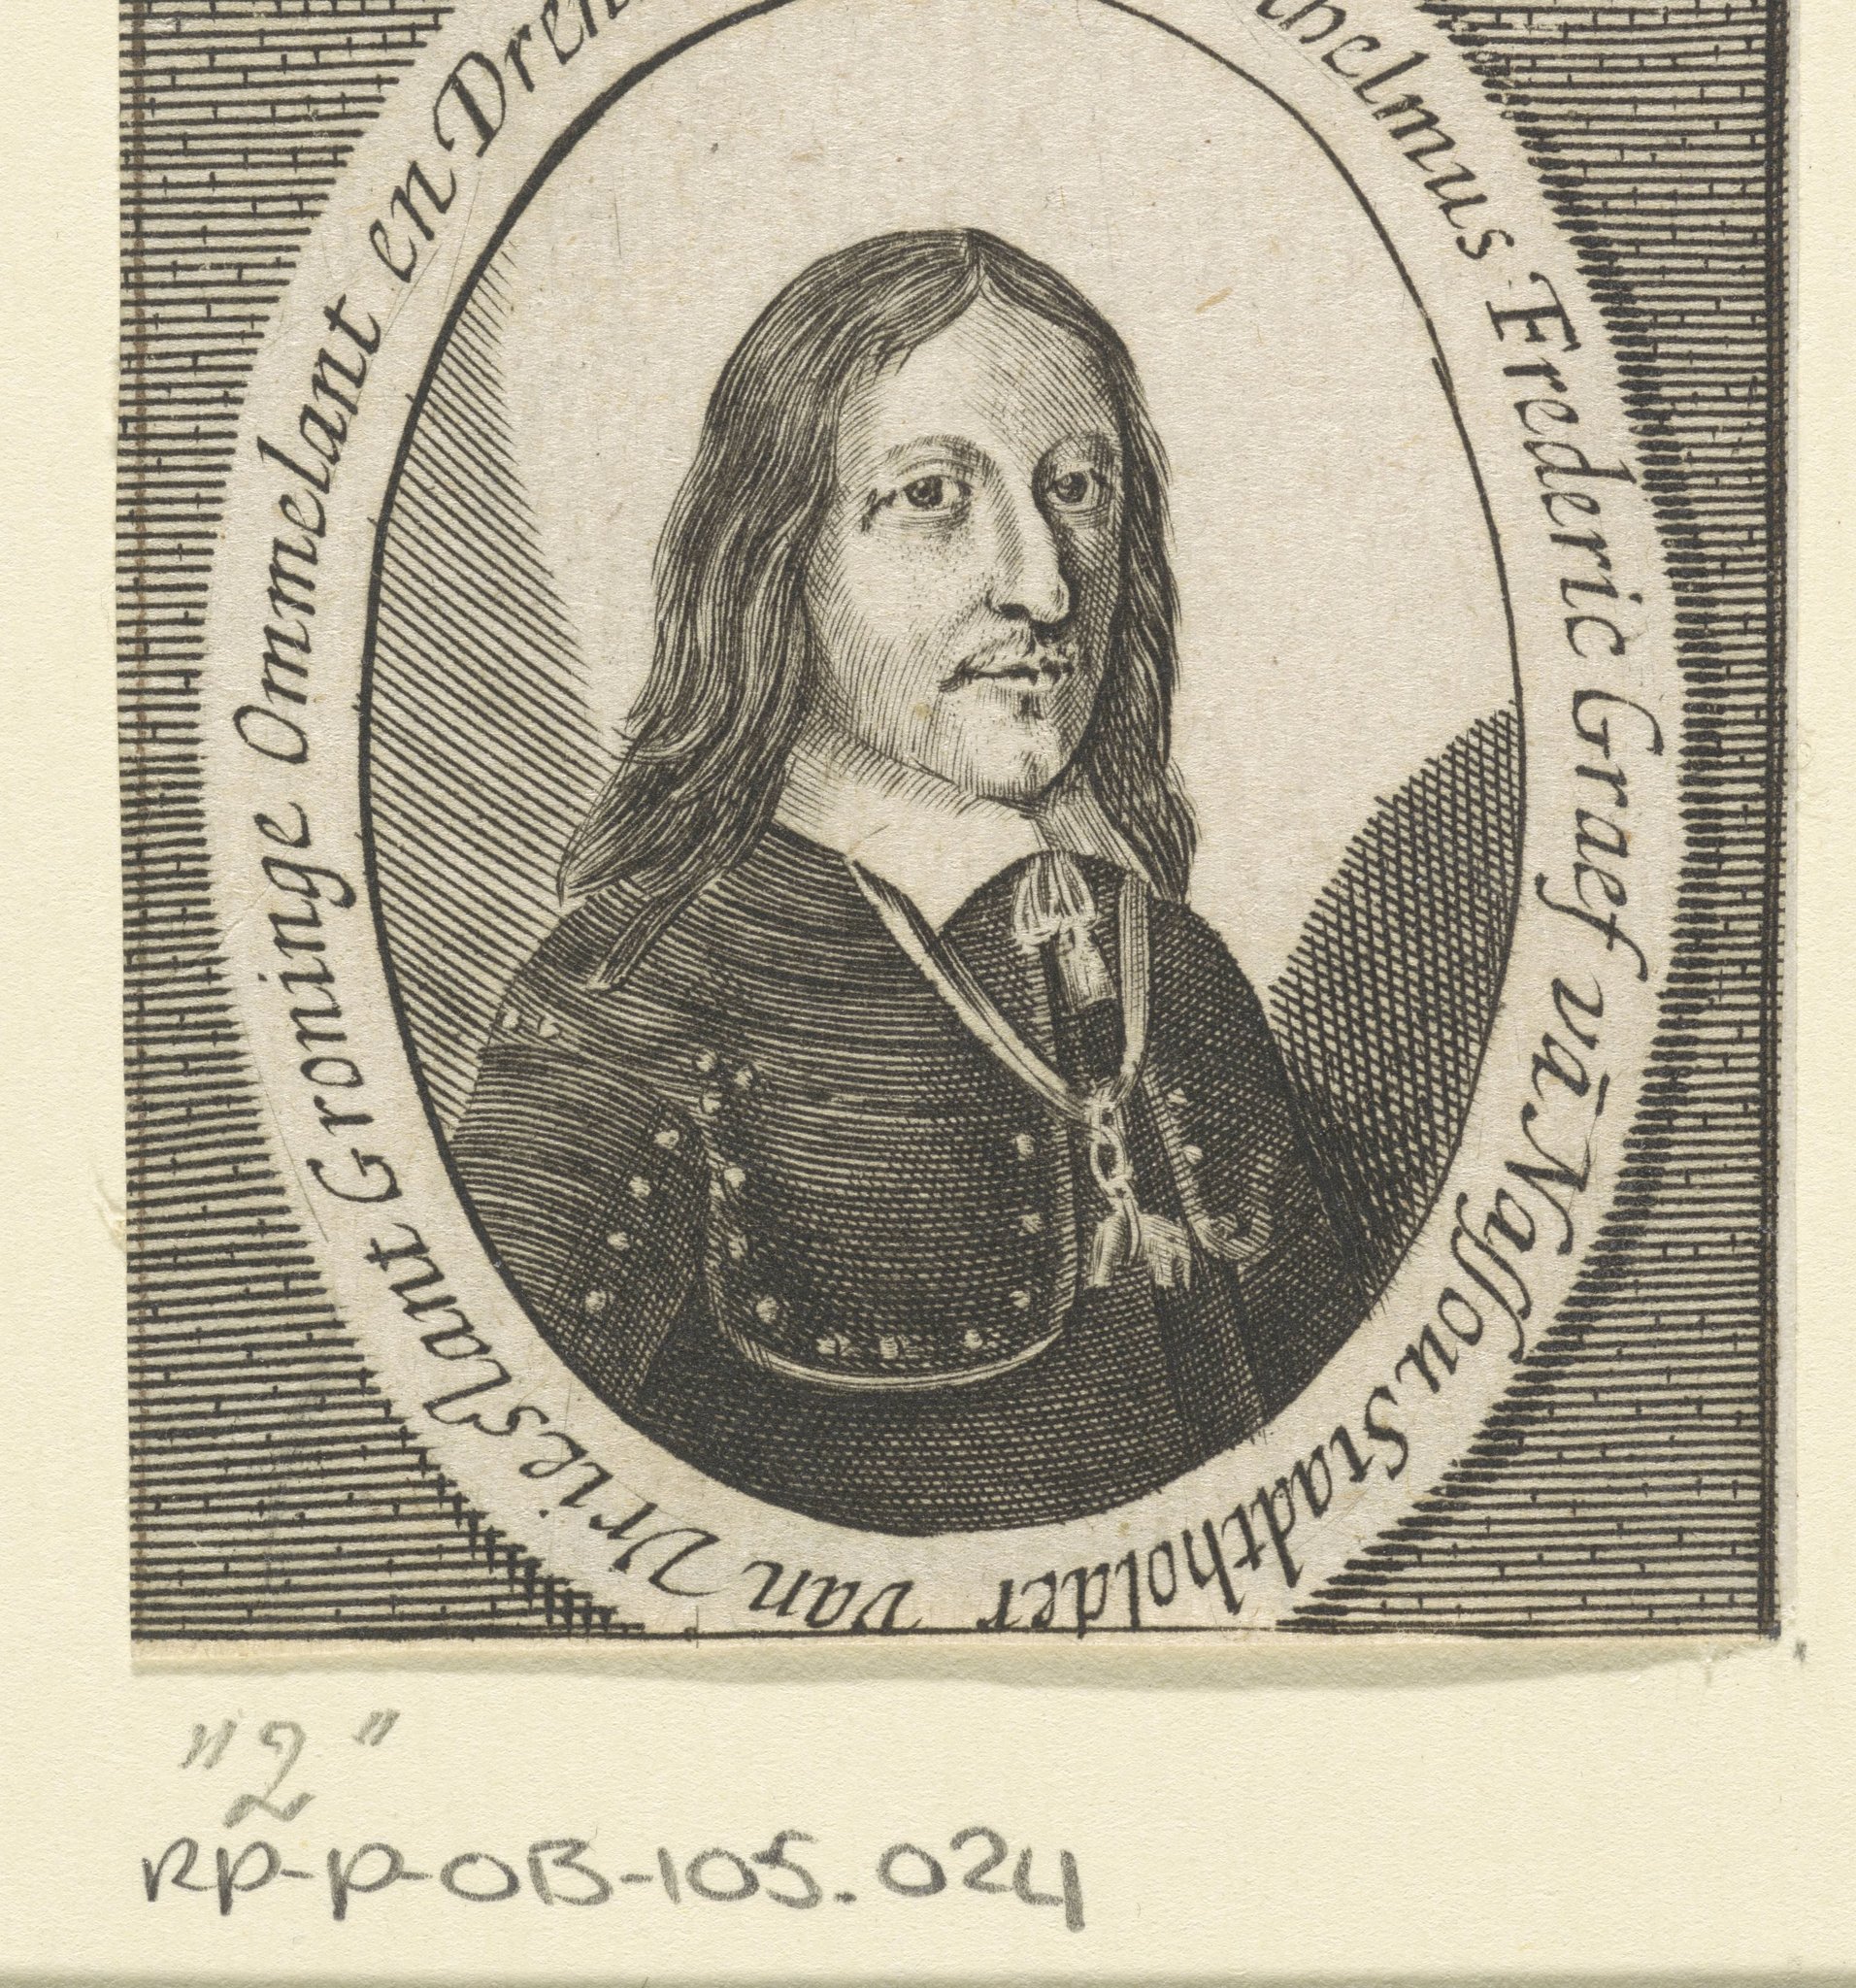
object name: print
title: Portret van Willem Frederik, graaf van Nassau-Dietz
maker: Anonymous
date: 1630-1699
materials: paper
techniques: engraving, etching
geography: low countries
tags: arnhem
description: De hier vermelde titel verwijst naar de hoogst verkregen titel van de geportretteerde, niet per se naar de titel die de geportretteerde op deze voorstelling draagt.